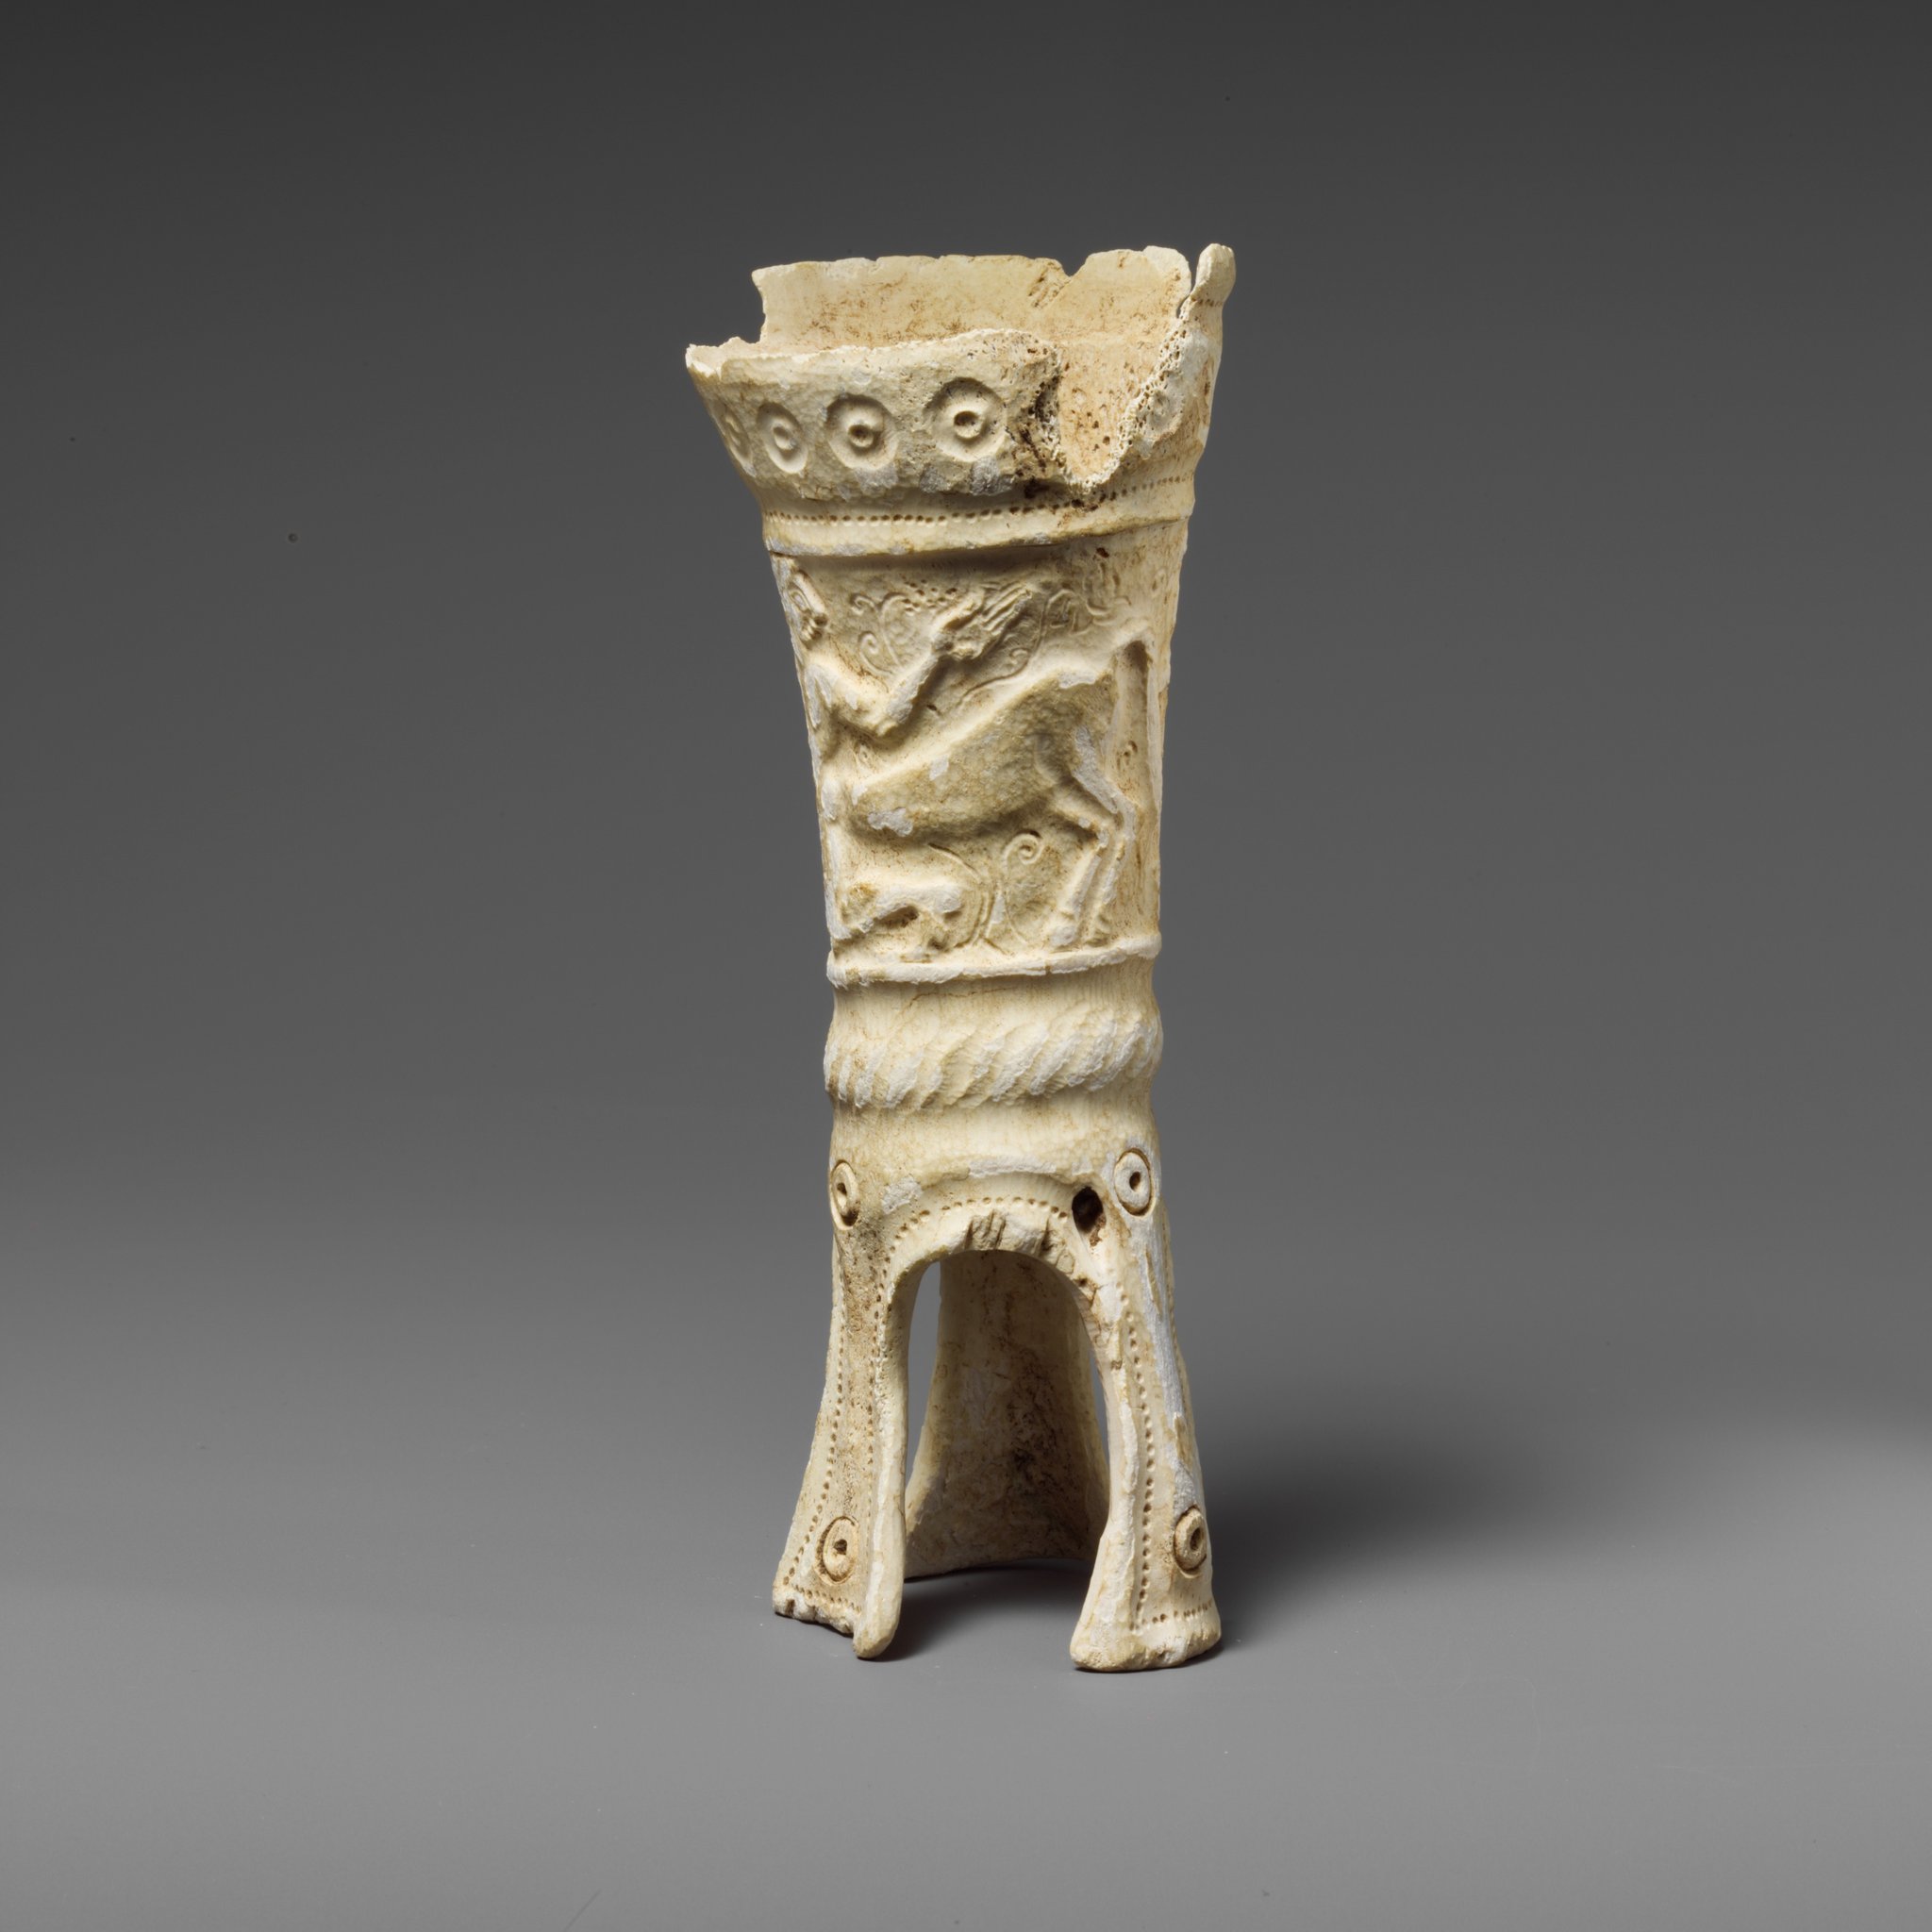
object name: stand with relief of a centaur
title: Bone stand with relief of a centaur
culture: greek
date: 550-500 BCE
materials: bone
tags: centaurs